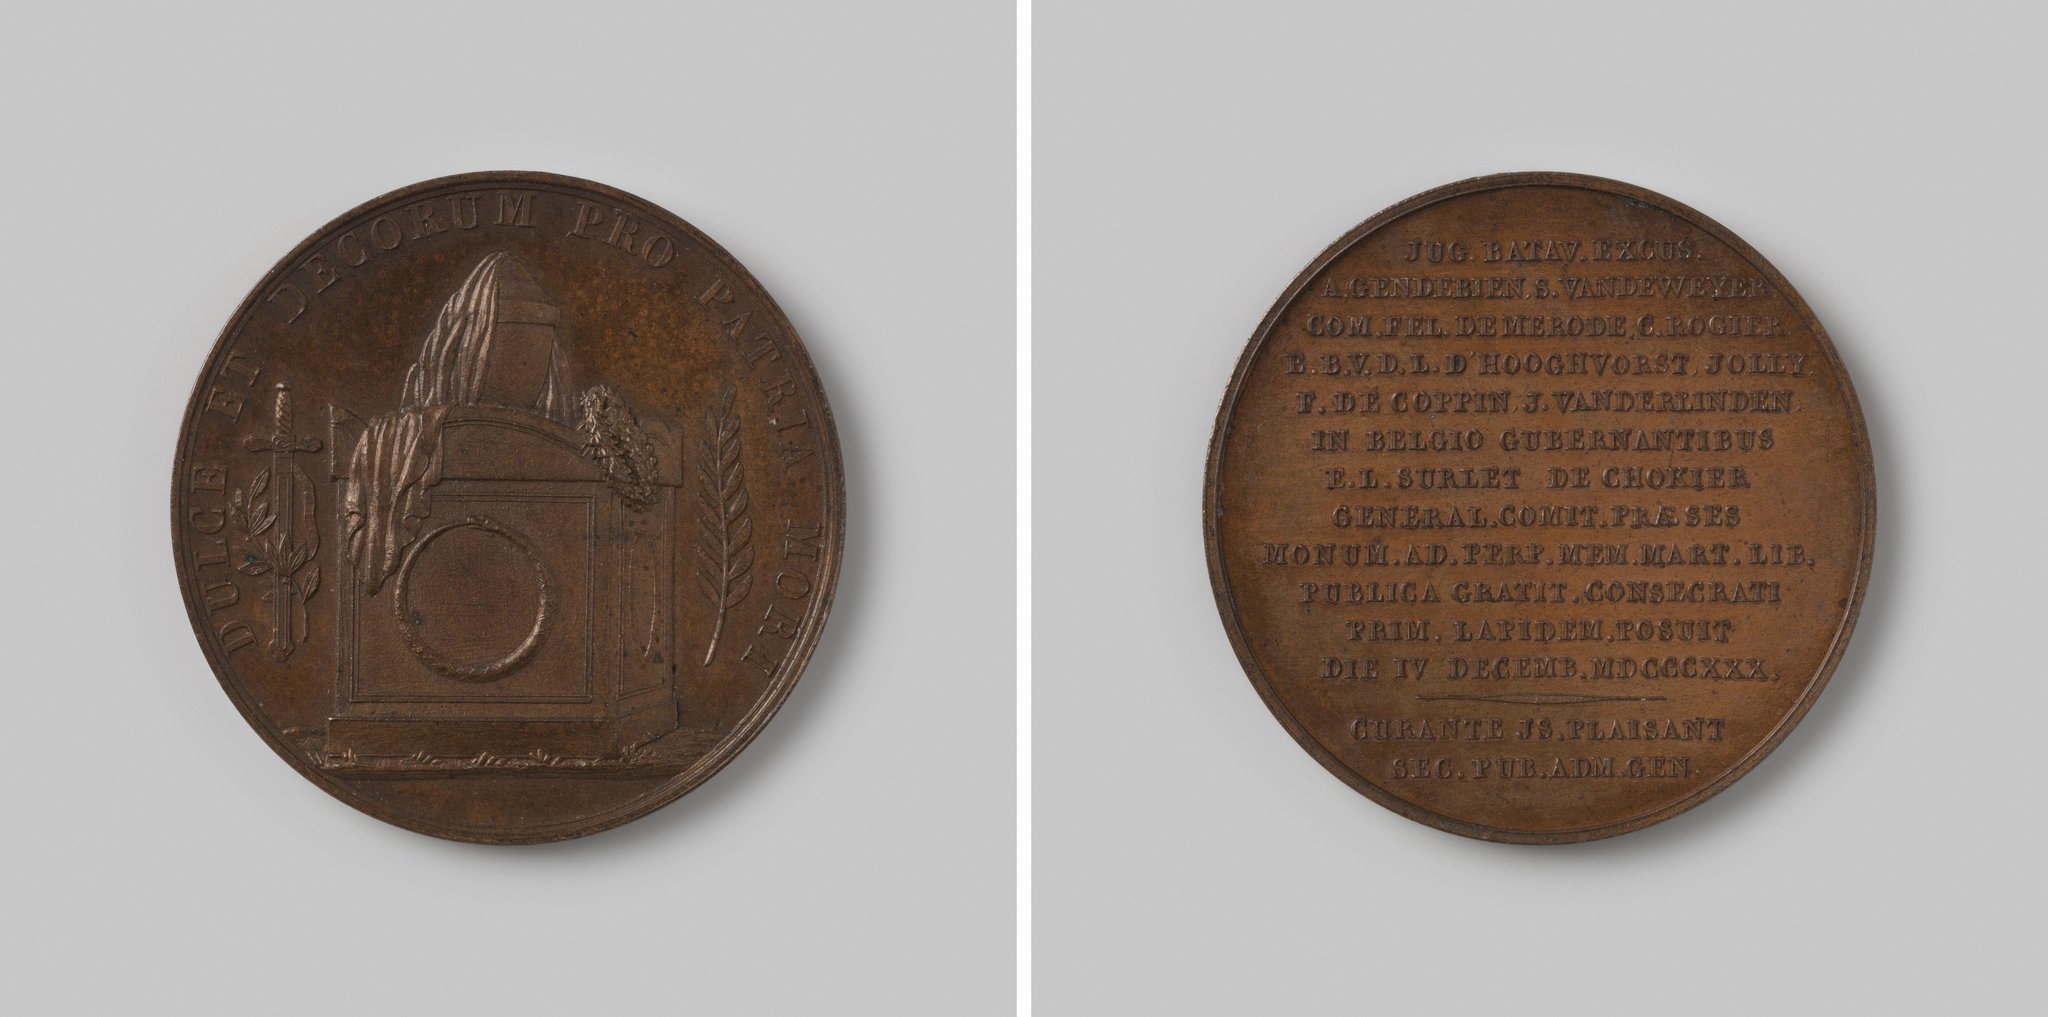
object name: history medal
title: Belgische gevallenen 1830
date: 1830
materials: bronze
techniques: striking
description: Bronzen penning, op de voorzijde een grafmonument waarop een urn tussen gelauwerd zwaard en een palmtak, met omschrift, op de keerzijde veertien regels tekst.